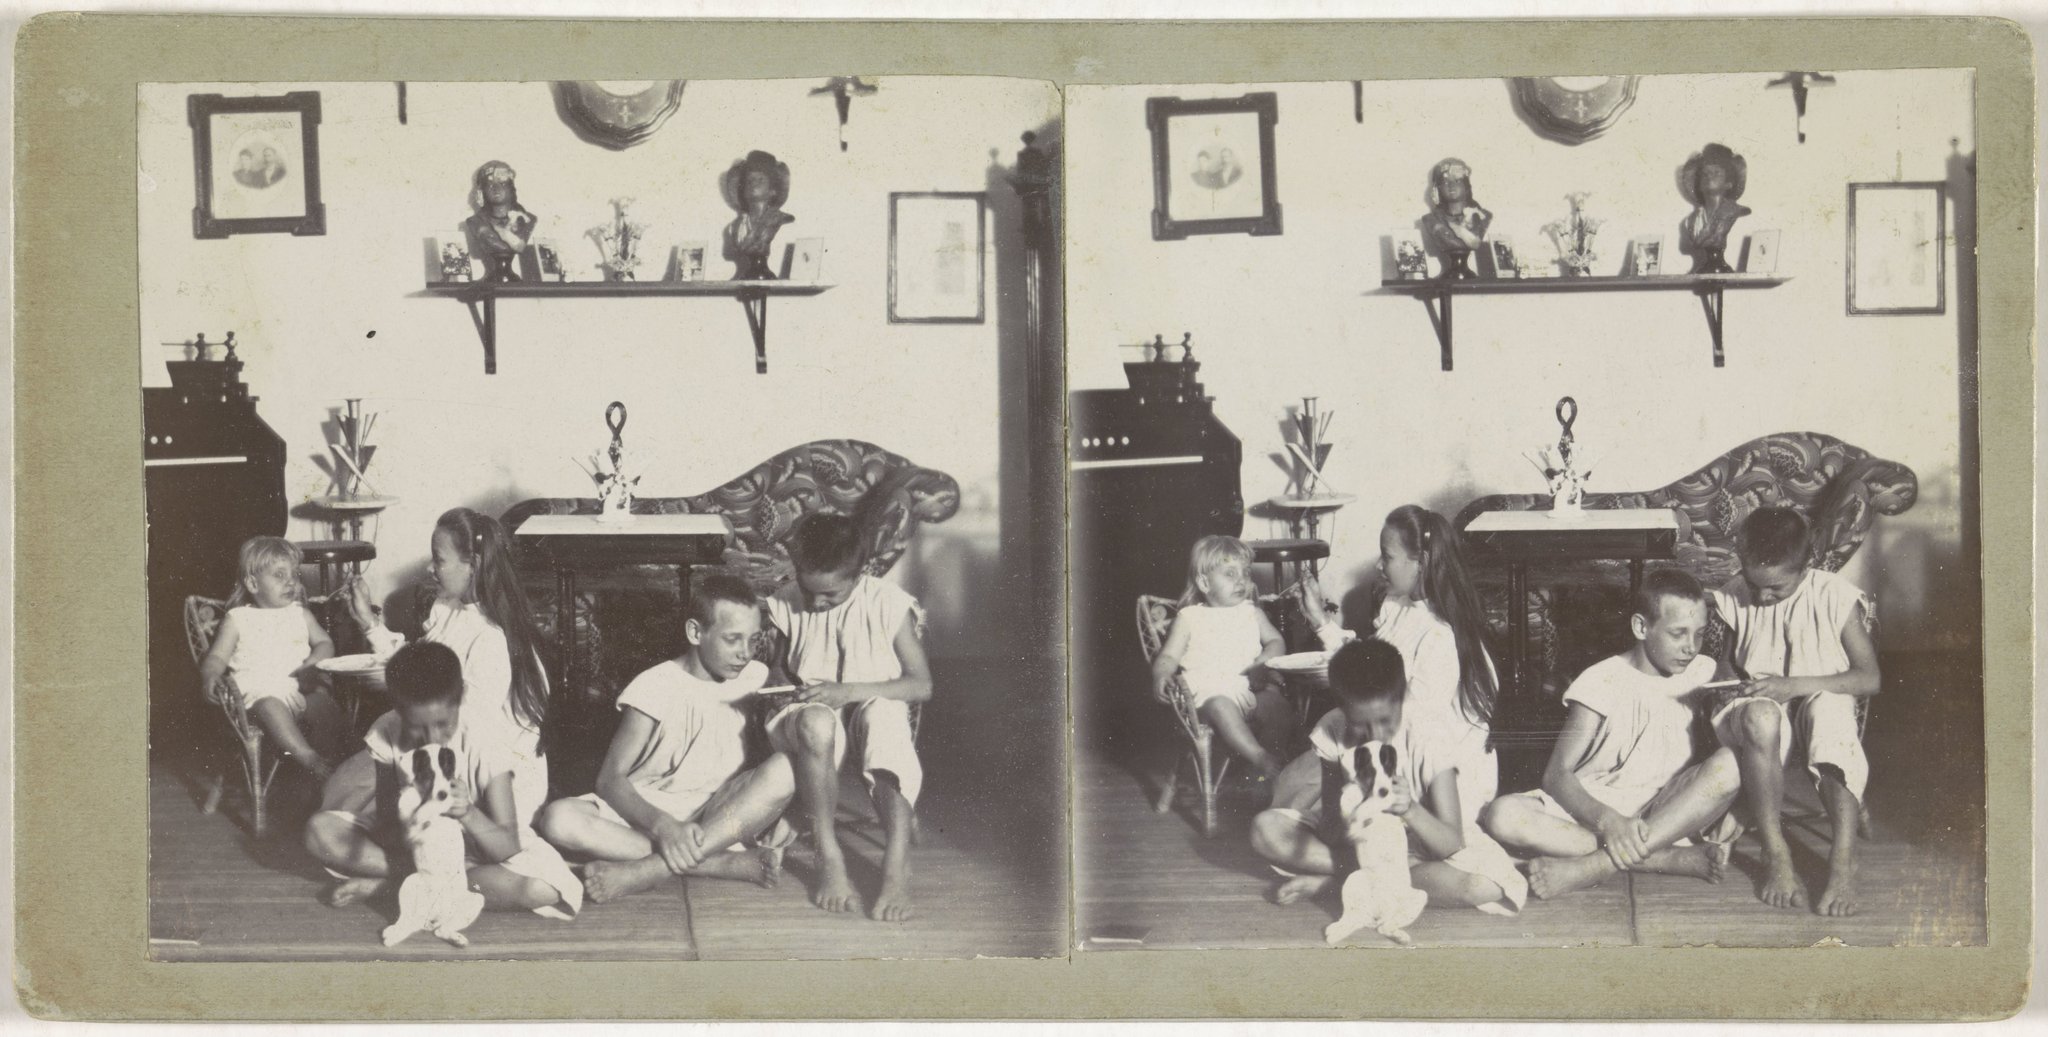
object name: stereograph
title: Vijf kinderen in een huiskamer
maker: Anonymous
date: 1904-1907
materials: cardboard, paper, photographic support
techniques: albumen print